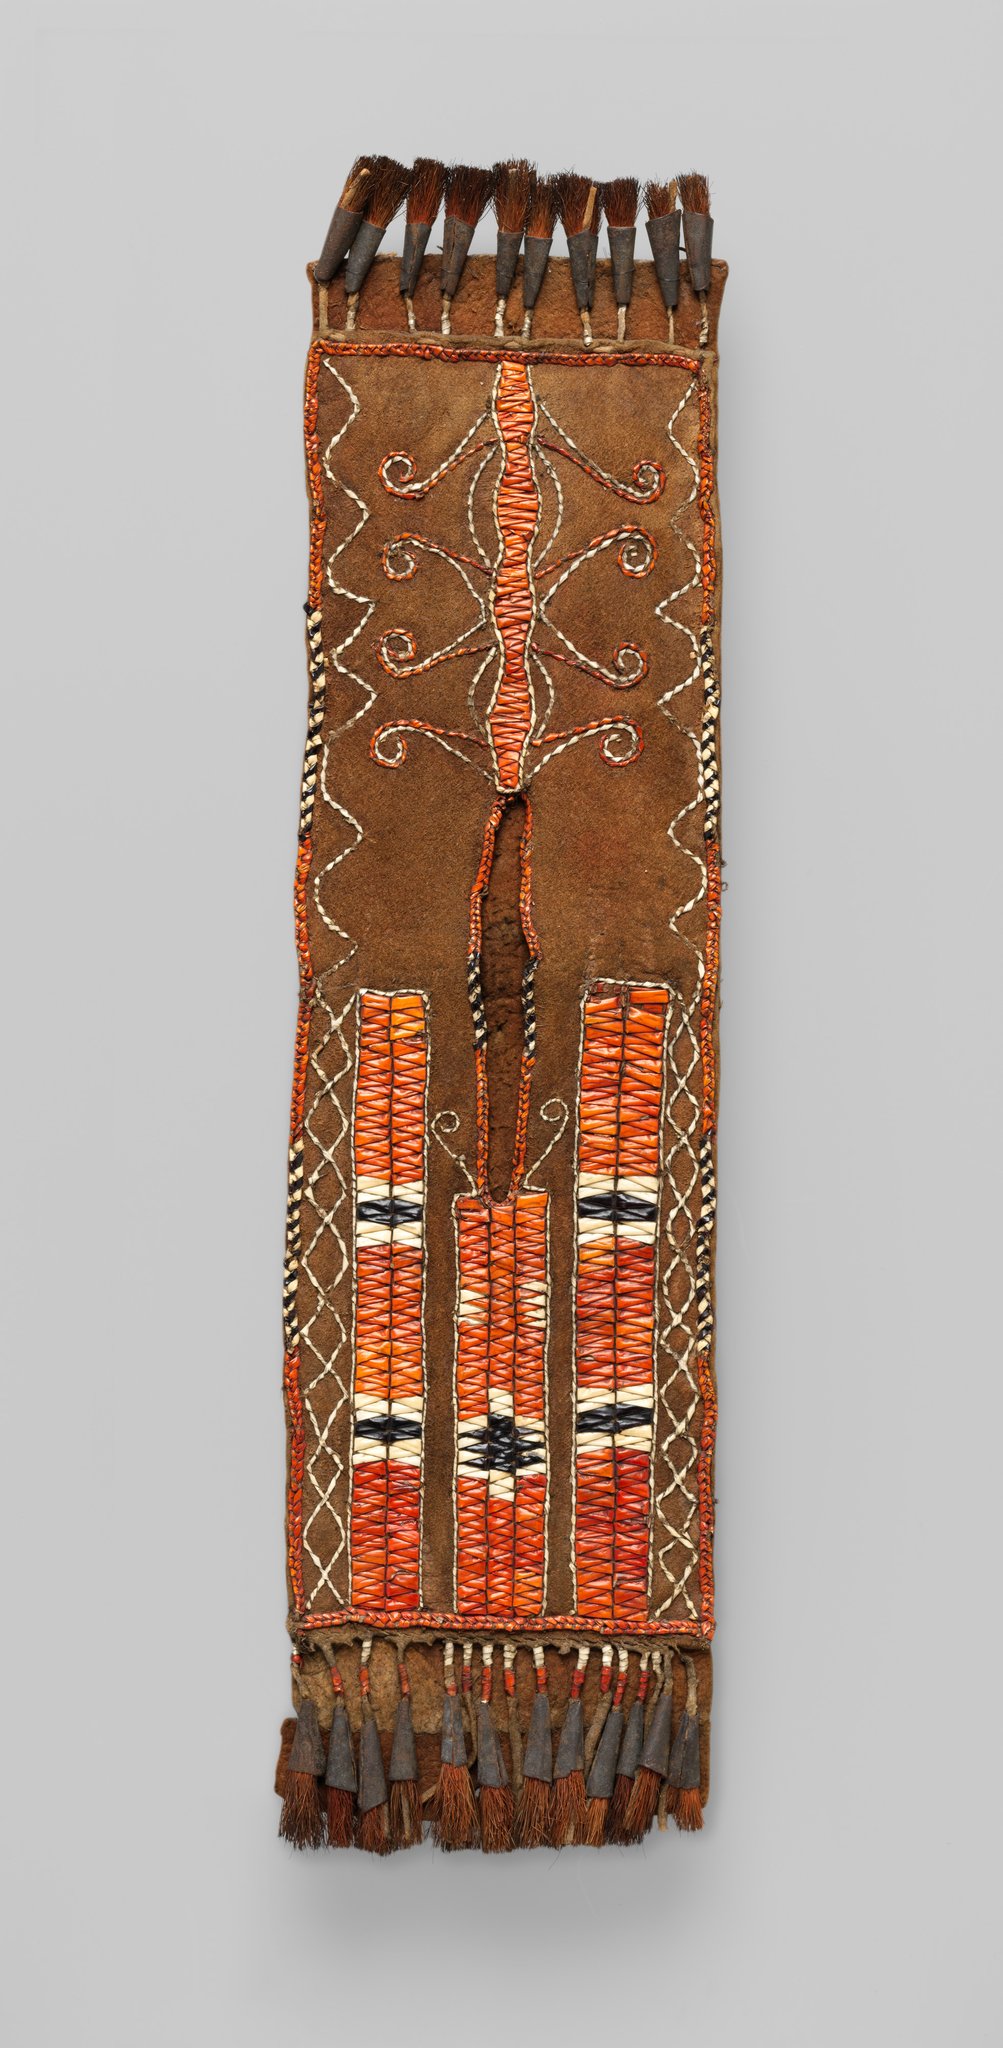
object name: belt pouch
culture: haudenosaunee or iroquois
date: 1800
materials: dye, hair, leather, metal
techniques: tanning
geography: canada